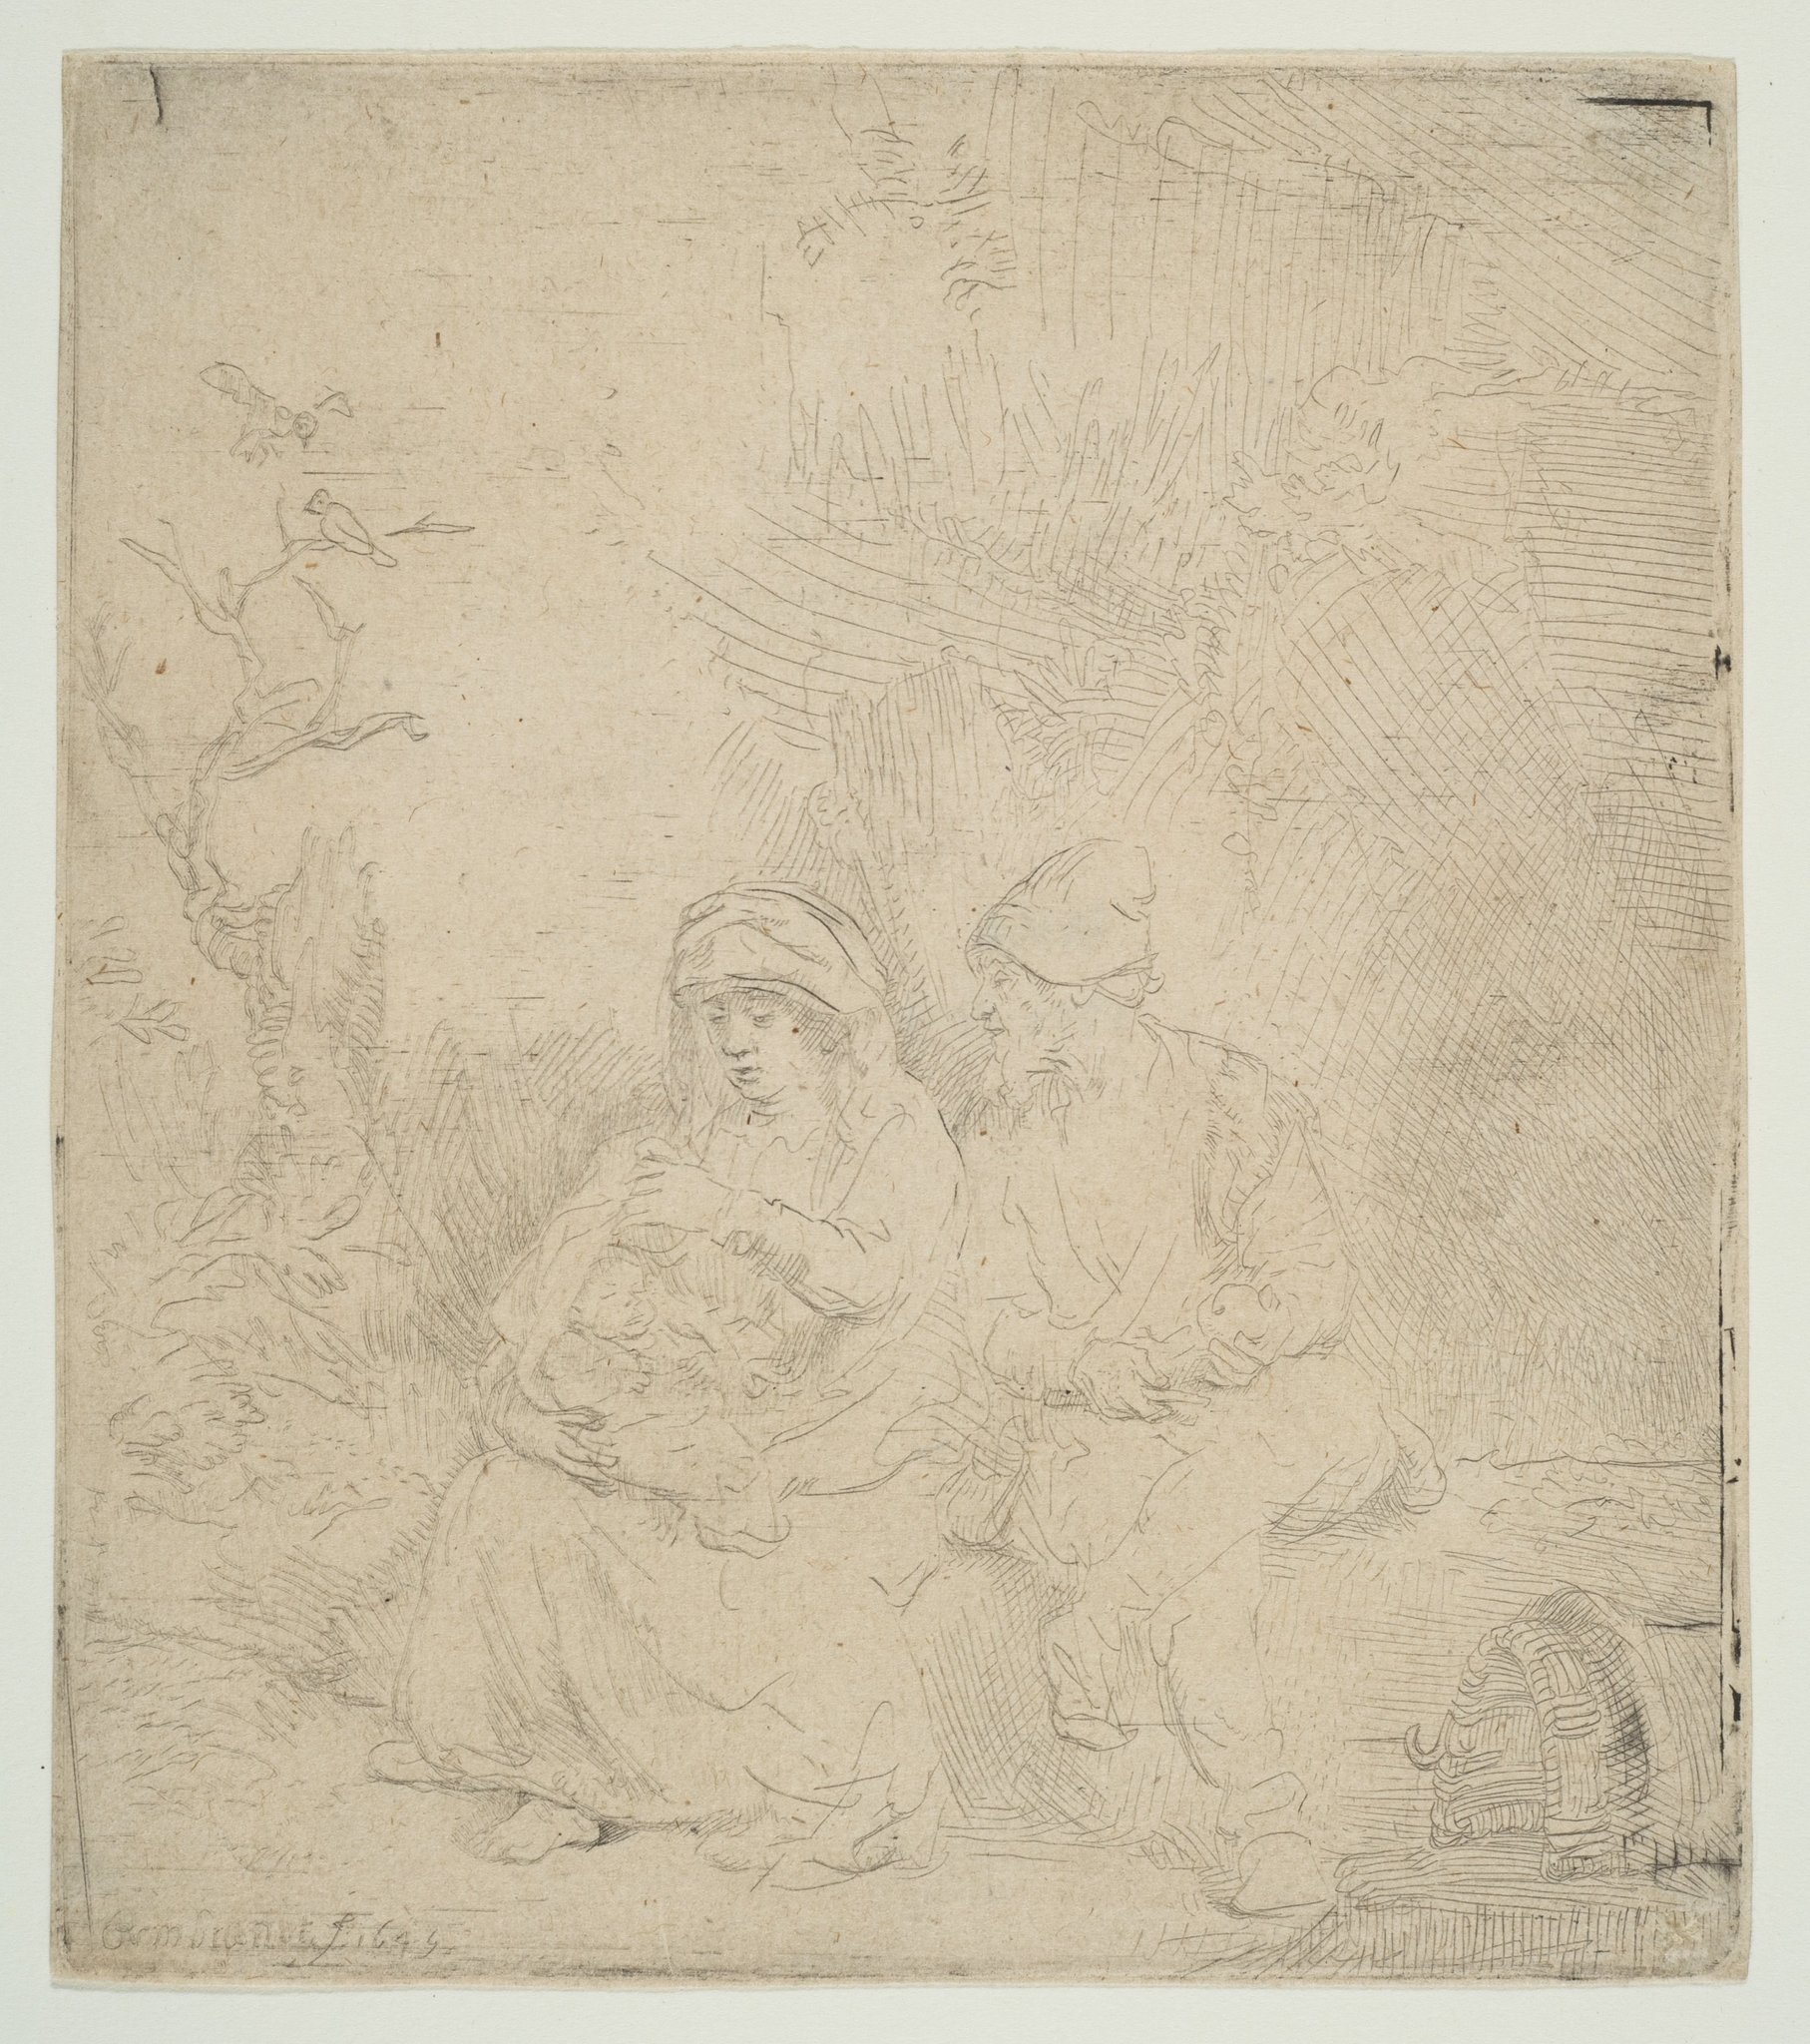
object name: print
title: The Rest on the Flight into Egypt; lightly etched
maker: rembrandt van rijn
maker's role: artist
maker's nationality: dutch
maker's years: 1606-1669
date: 1645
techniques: drypoint, etching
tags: infants,men,women